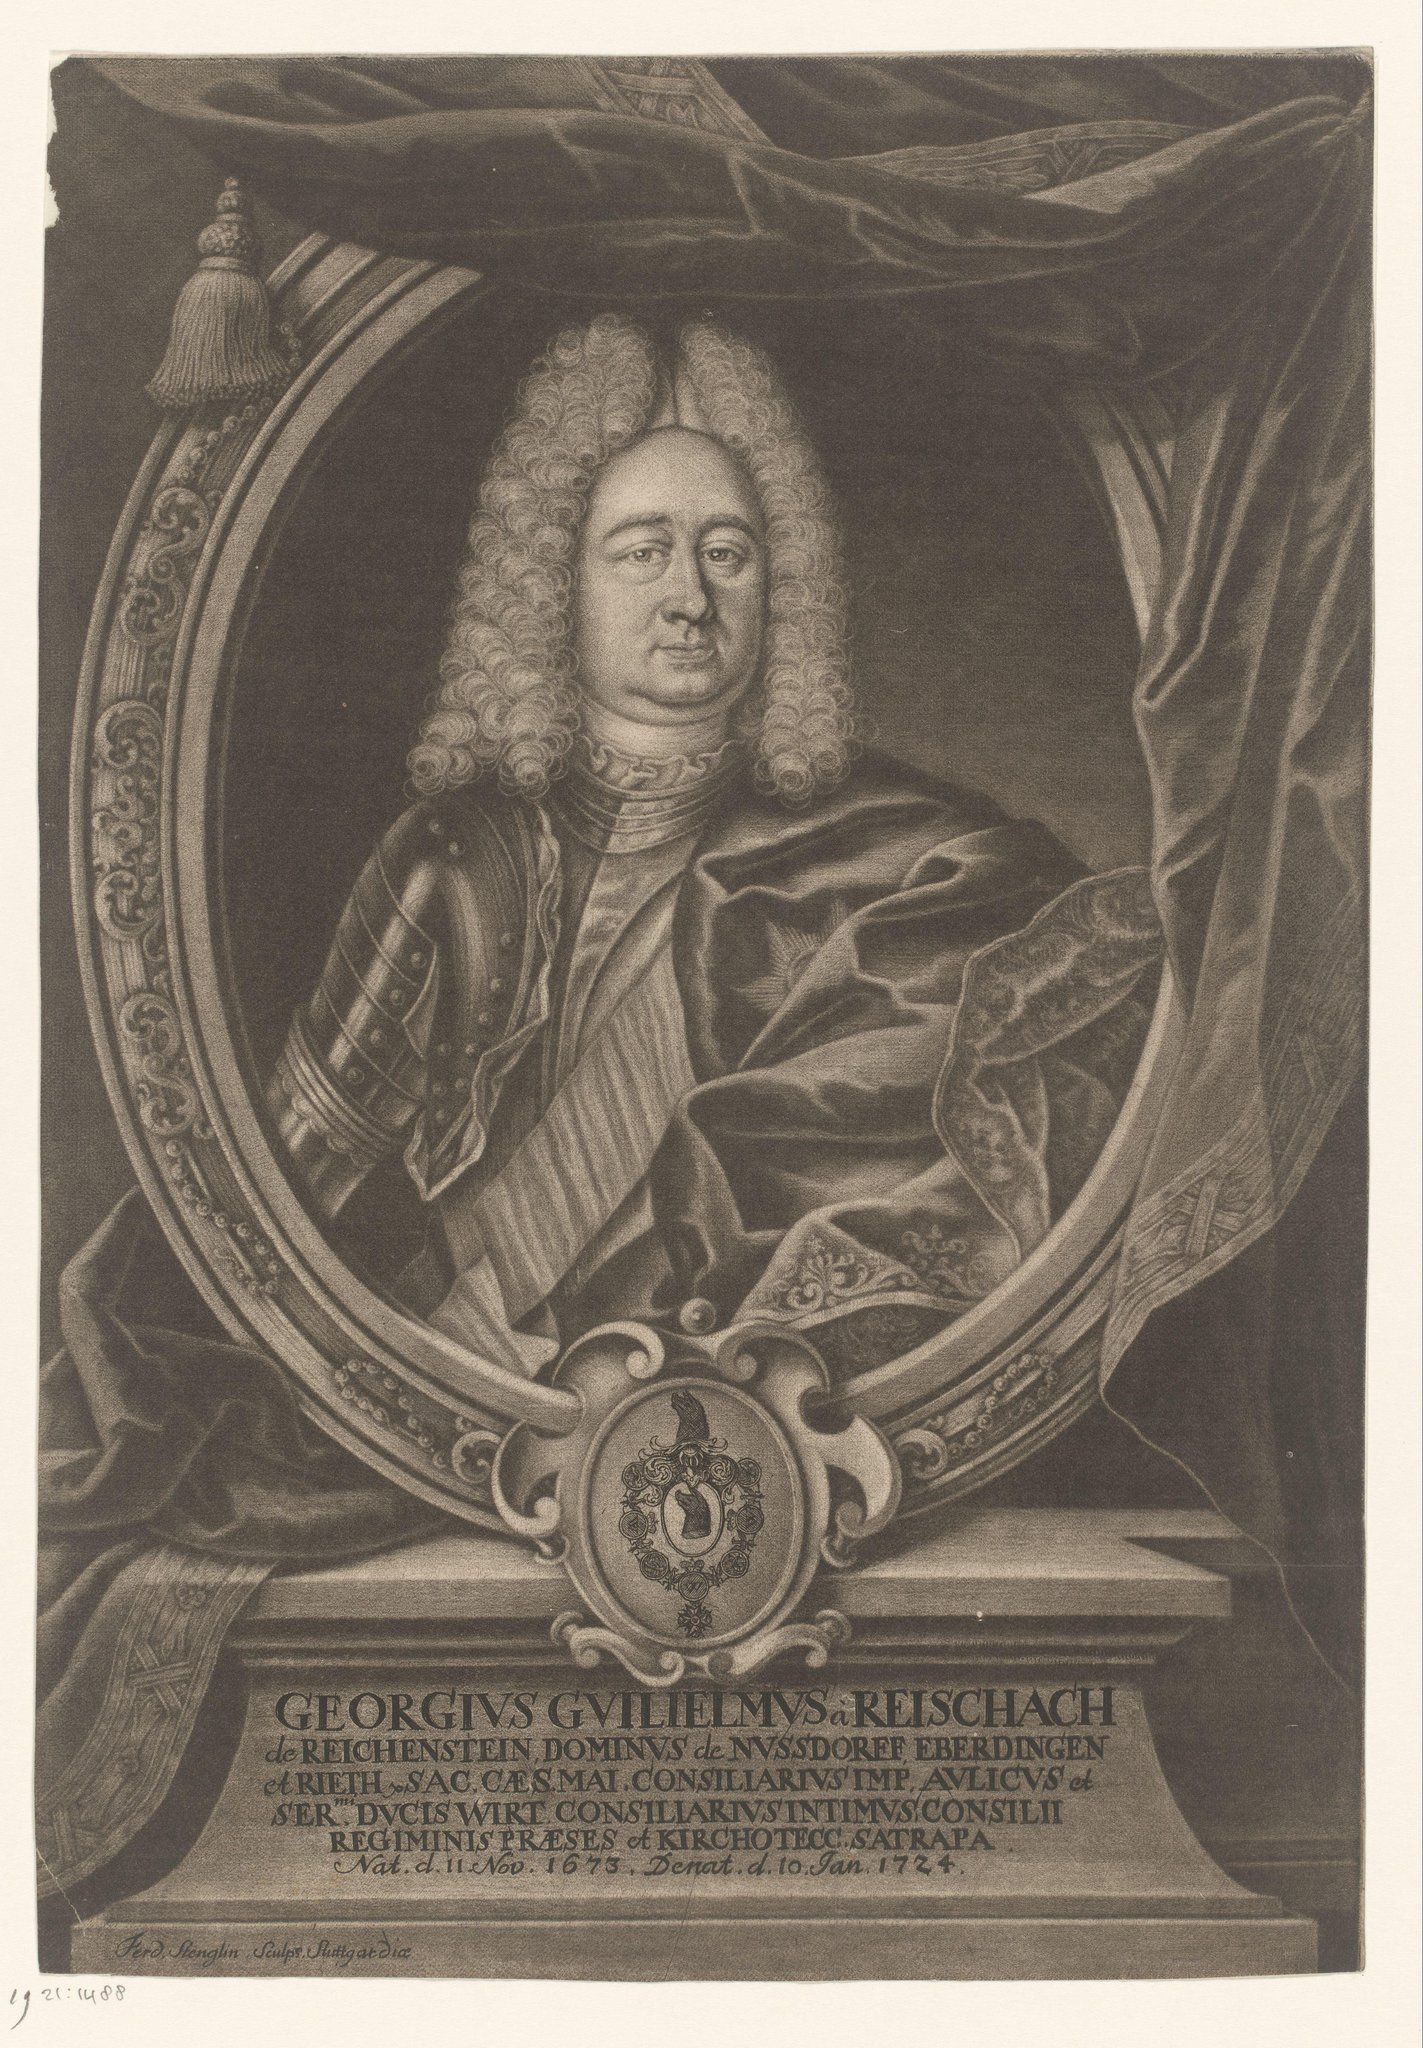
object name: print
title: Portret van Georg Wilhelm von Reischach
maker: ferdinand stenglin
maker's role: print maker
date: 1724-1799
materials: paper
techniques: mezzotint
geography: stuttgart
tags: historical persons, armorial bearing, heraldry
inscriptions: collector's mark: Lugt 2228